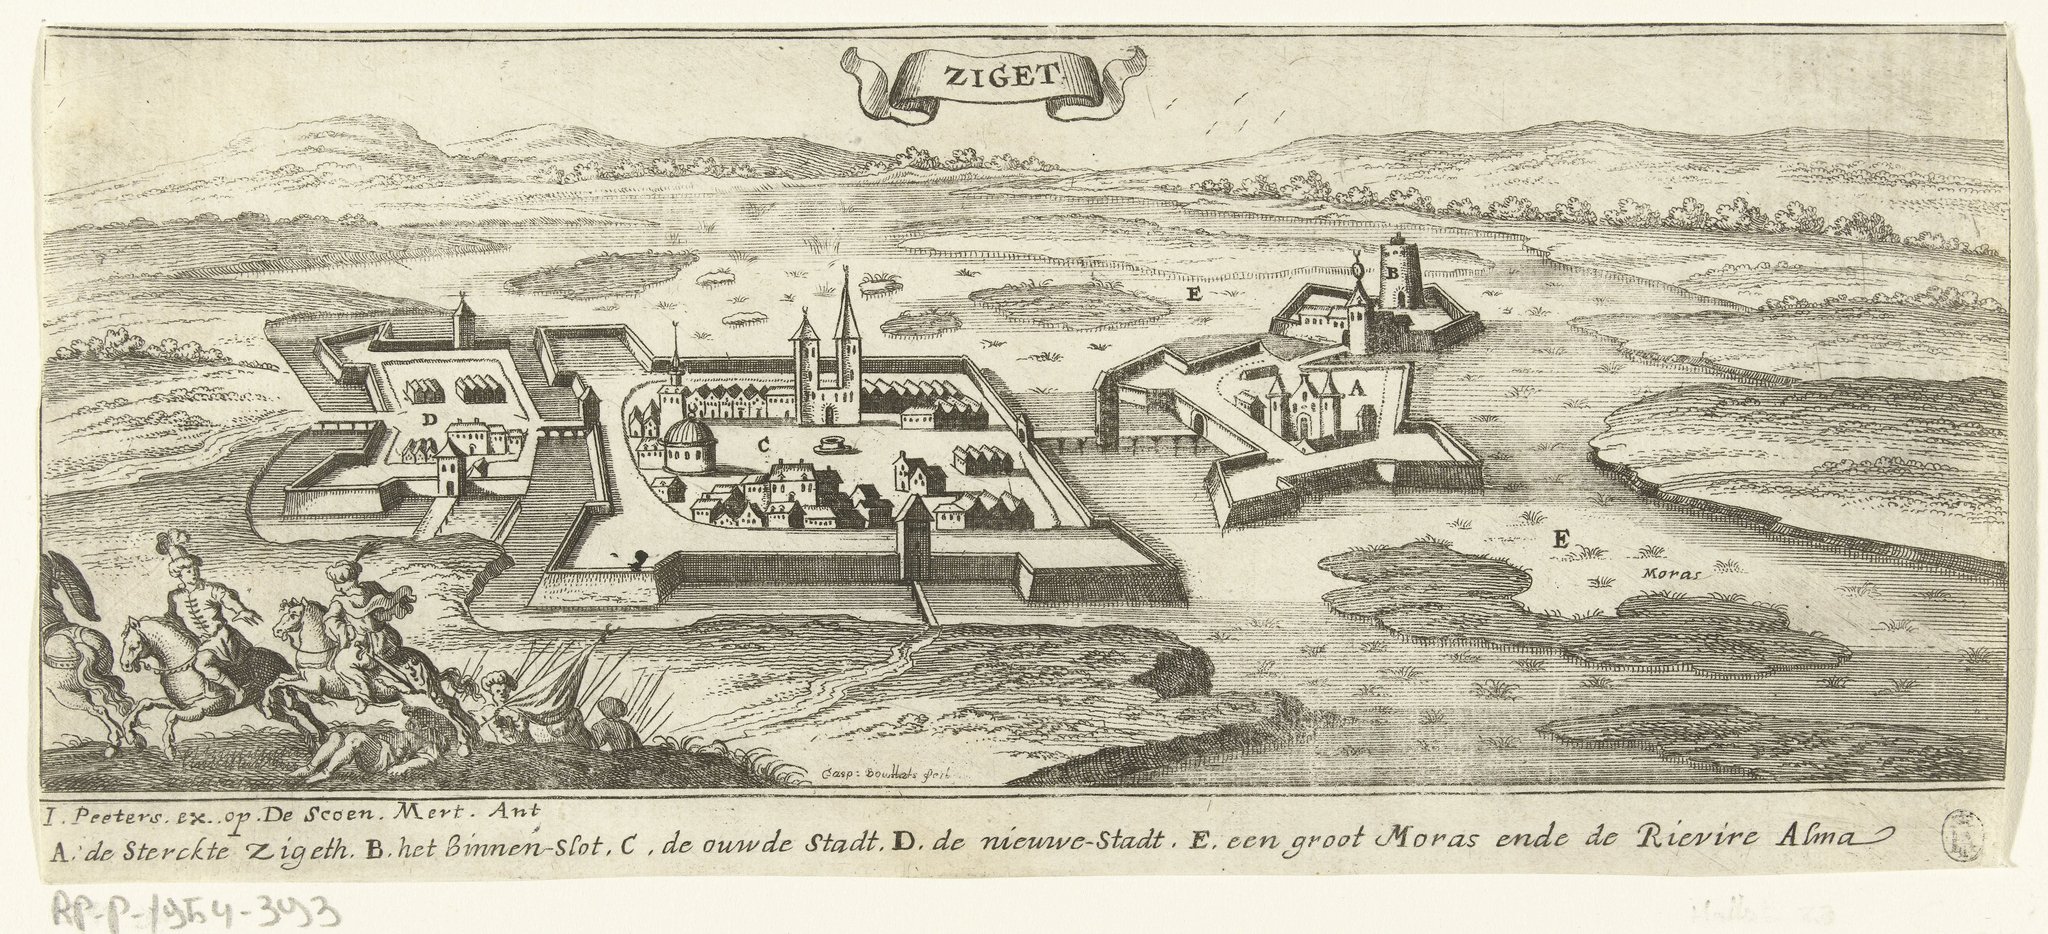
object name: print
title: Topografische afbeeldingen van Oostenrijk, Hongarije en de Balkan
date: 1686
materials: paper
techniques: etching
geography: antwerp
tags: prospect of city, town panorama, silhouette of city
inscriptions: collector's mark: Lugt 971, collector's mark: Lugt 2228, collector's mark: Lugt 2760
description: Gezicht op de burchtstad Szigetvár. Op de voorgrond, buiten de stadsmuren, een legereenheid die vlucht na een schermutseling. Boven het stadsgezicht een cartouche met de naam van de stad. De prent heeft een Nederlands onderschrift met verwijzingen naar gebouwen op de prent.